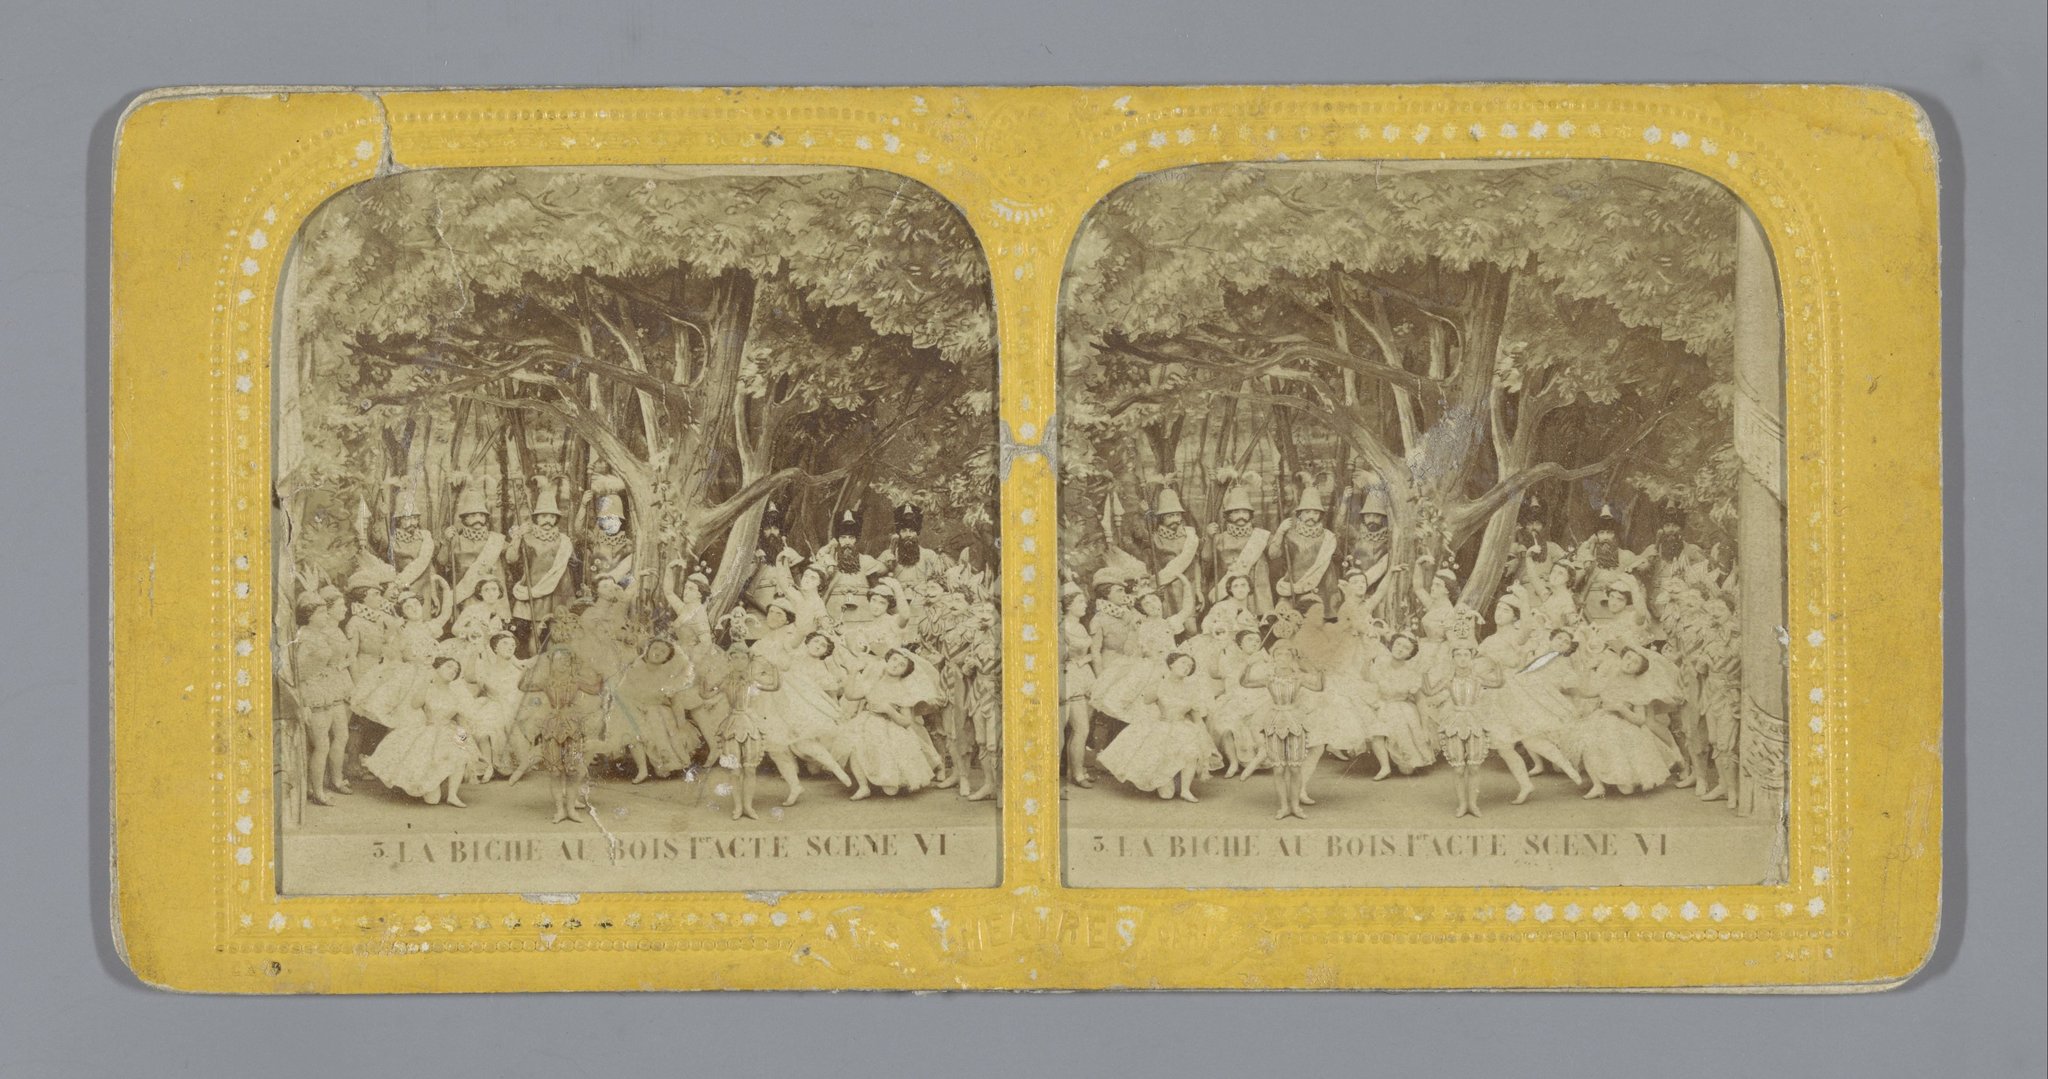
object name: tissue stereograph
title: Eerste bedrijf, zesde scène van La biche au bois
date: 1873-1874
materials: cardboard, paper, photographic support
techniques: albumen print, cutting, hand coloring, perforating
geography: paris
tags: opera, paris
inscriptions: number: ‘3.’, inscription: ‘Toutes les épreuves non revêtues du timbre ci-contre/ seront considérées comme contrefacon, le Dépôt/ ayant été fait en France selon la loi et à l' Etranger/ conformément aux conventions internationales./ PROPRIÉTÉ/ B.K./ PARIS’